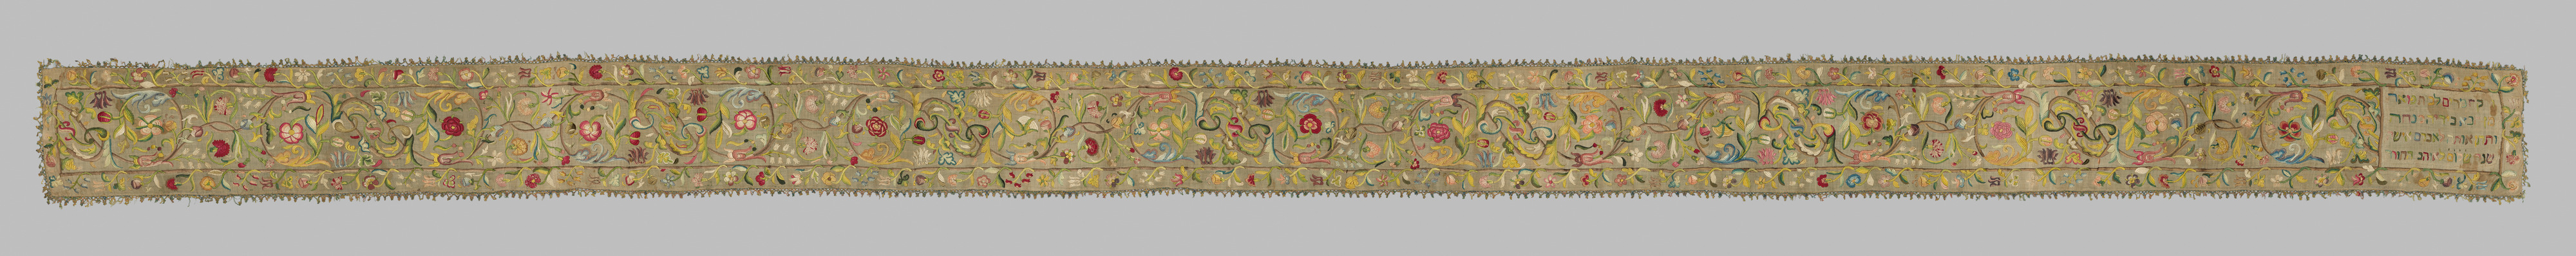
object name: torah binder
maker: miriam foa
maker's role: maker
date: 1615-1616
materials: lace, linen, silk, textile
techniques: embroidery, weave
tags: flowers